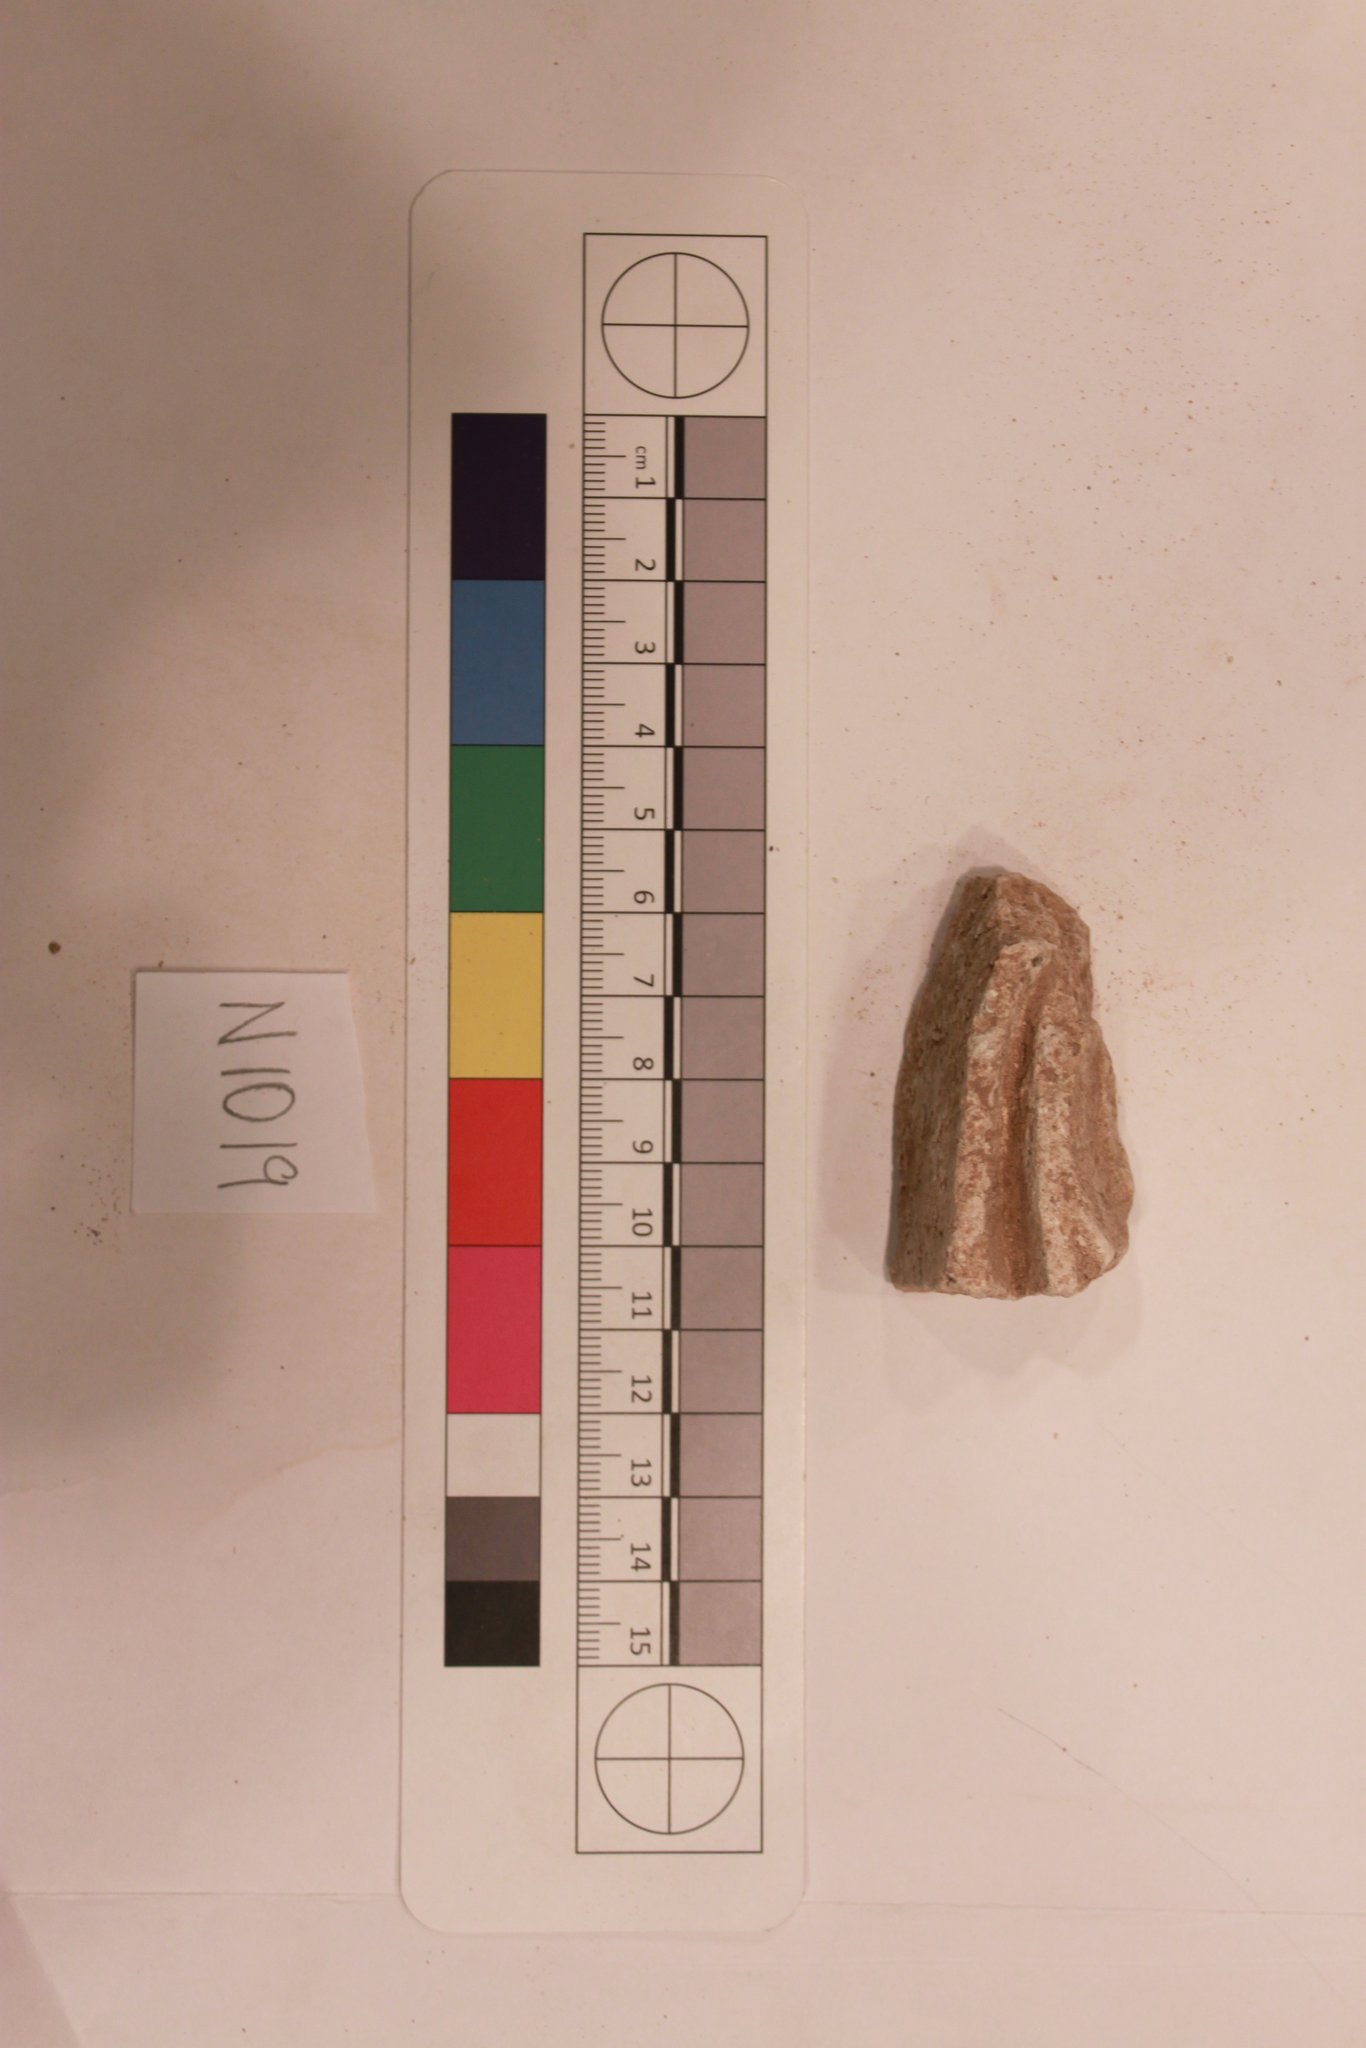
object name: fragment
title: Stucco Fragment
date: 701-1200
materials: plaster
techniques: carving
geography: iran